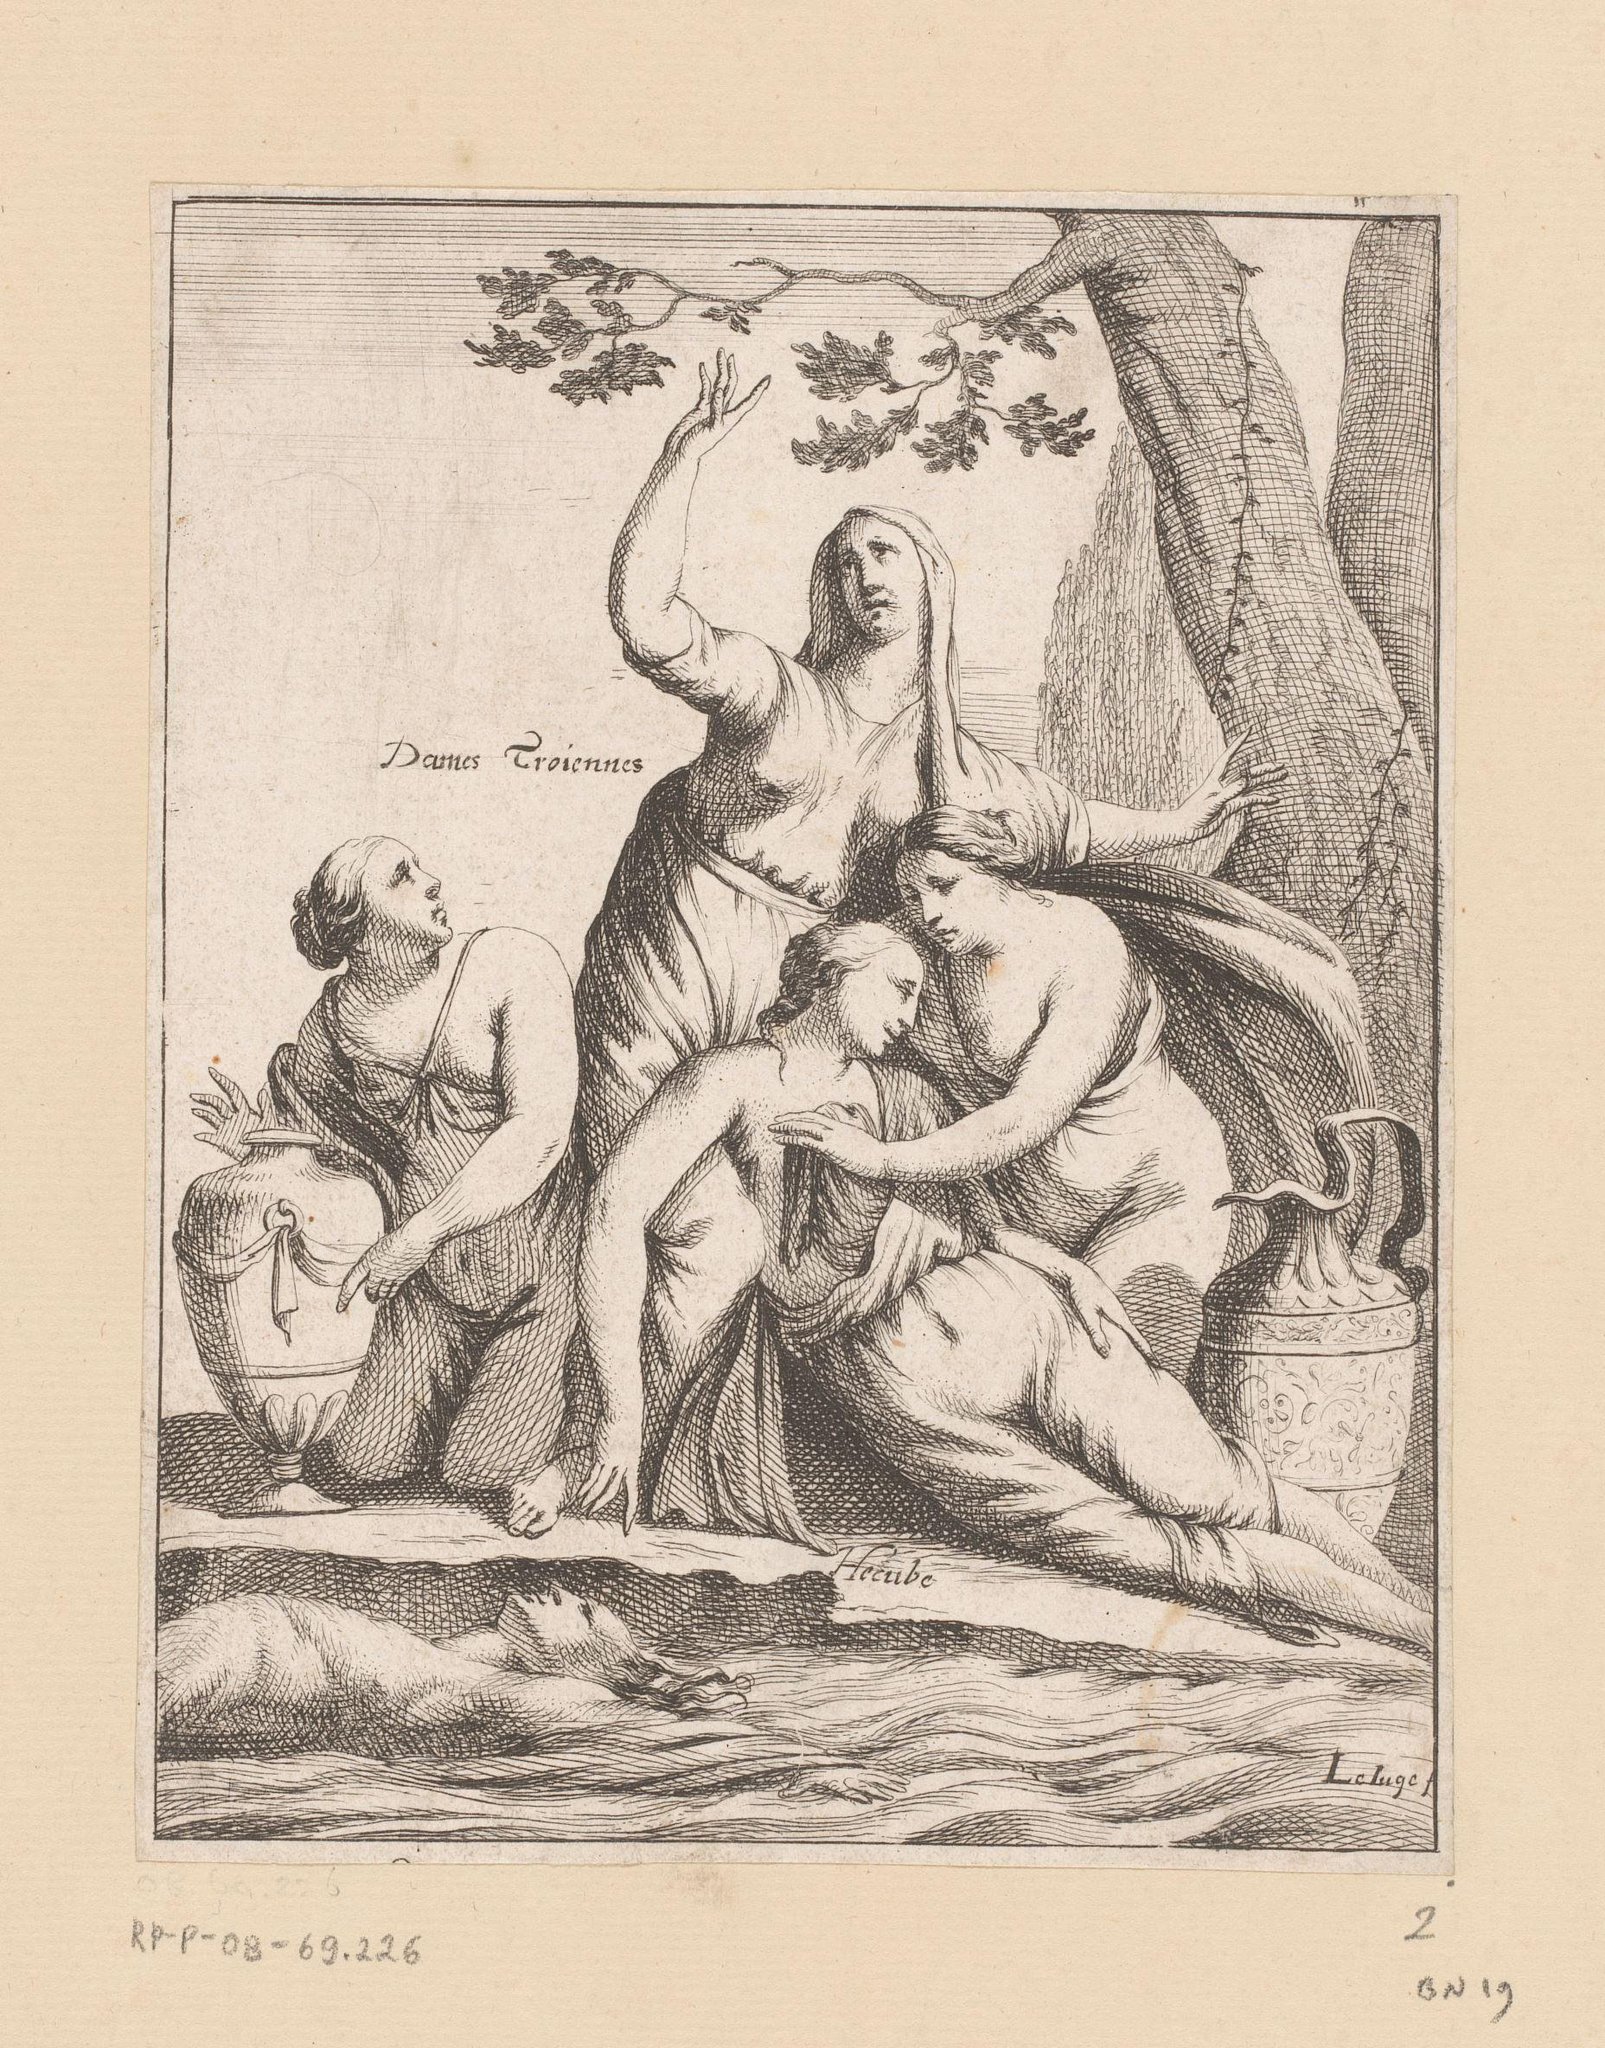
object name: print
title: Hekabe met drie Trojaanse vrouwen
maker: georges le juge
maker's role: publisher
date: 1648-1671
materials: paper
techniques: engraving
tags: (story of) hecuba